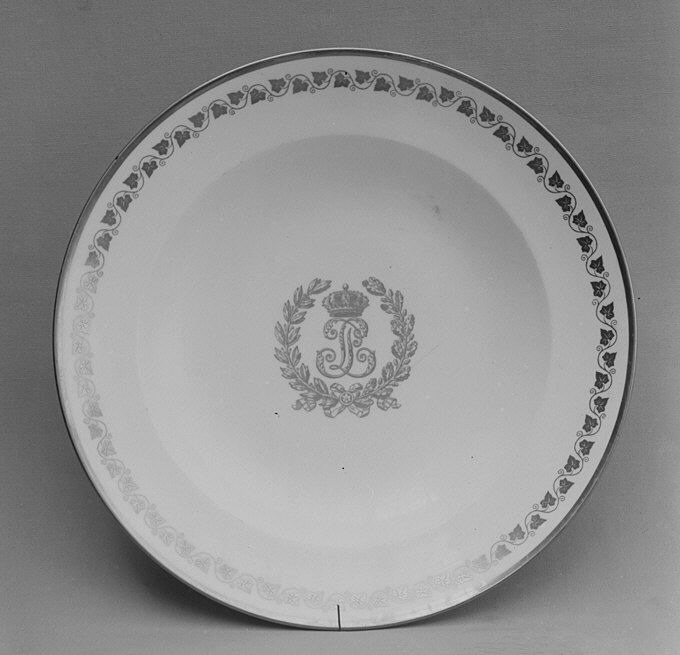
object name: soup plate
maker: sèvres manufactory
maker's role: manufactory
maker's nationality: french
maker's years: 1740-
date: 1833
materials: soft paste porcelain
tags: wreaths,insignia